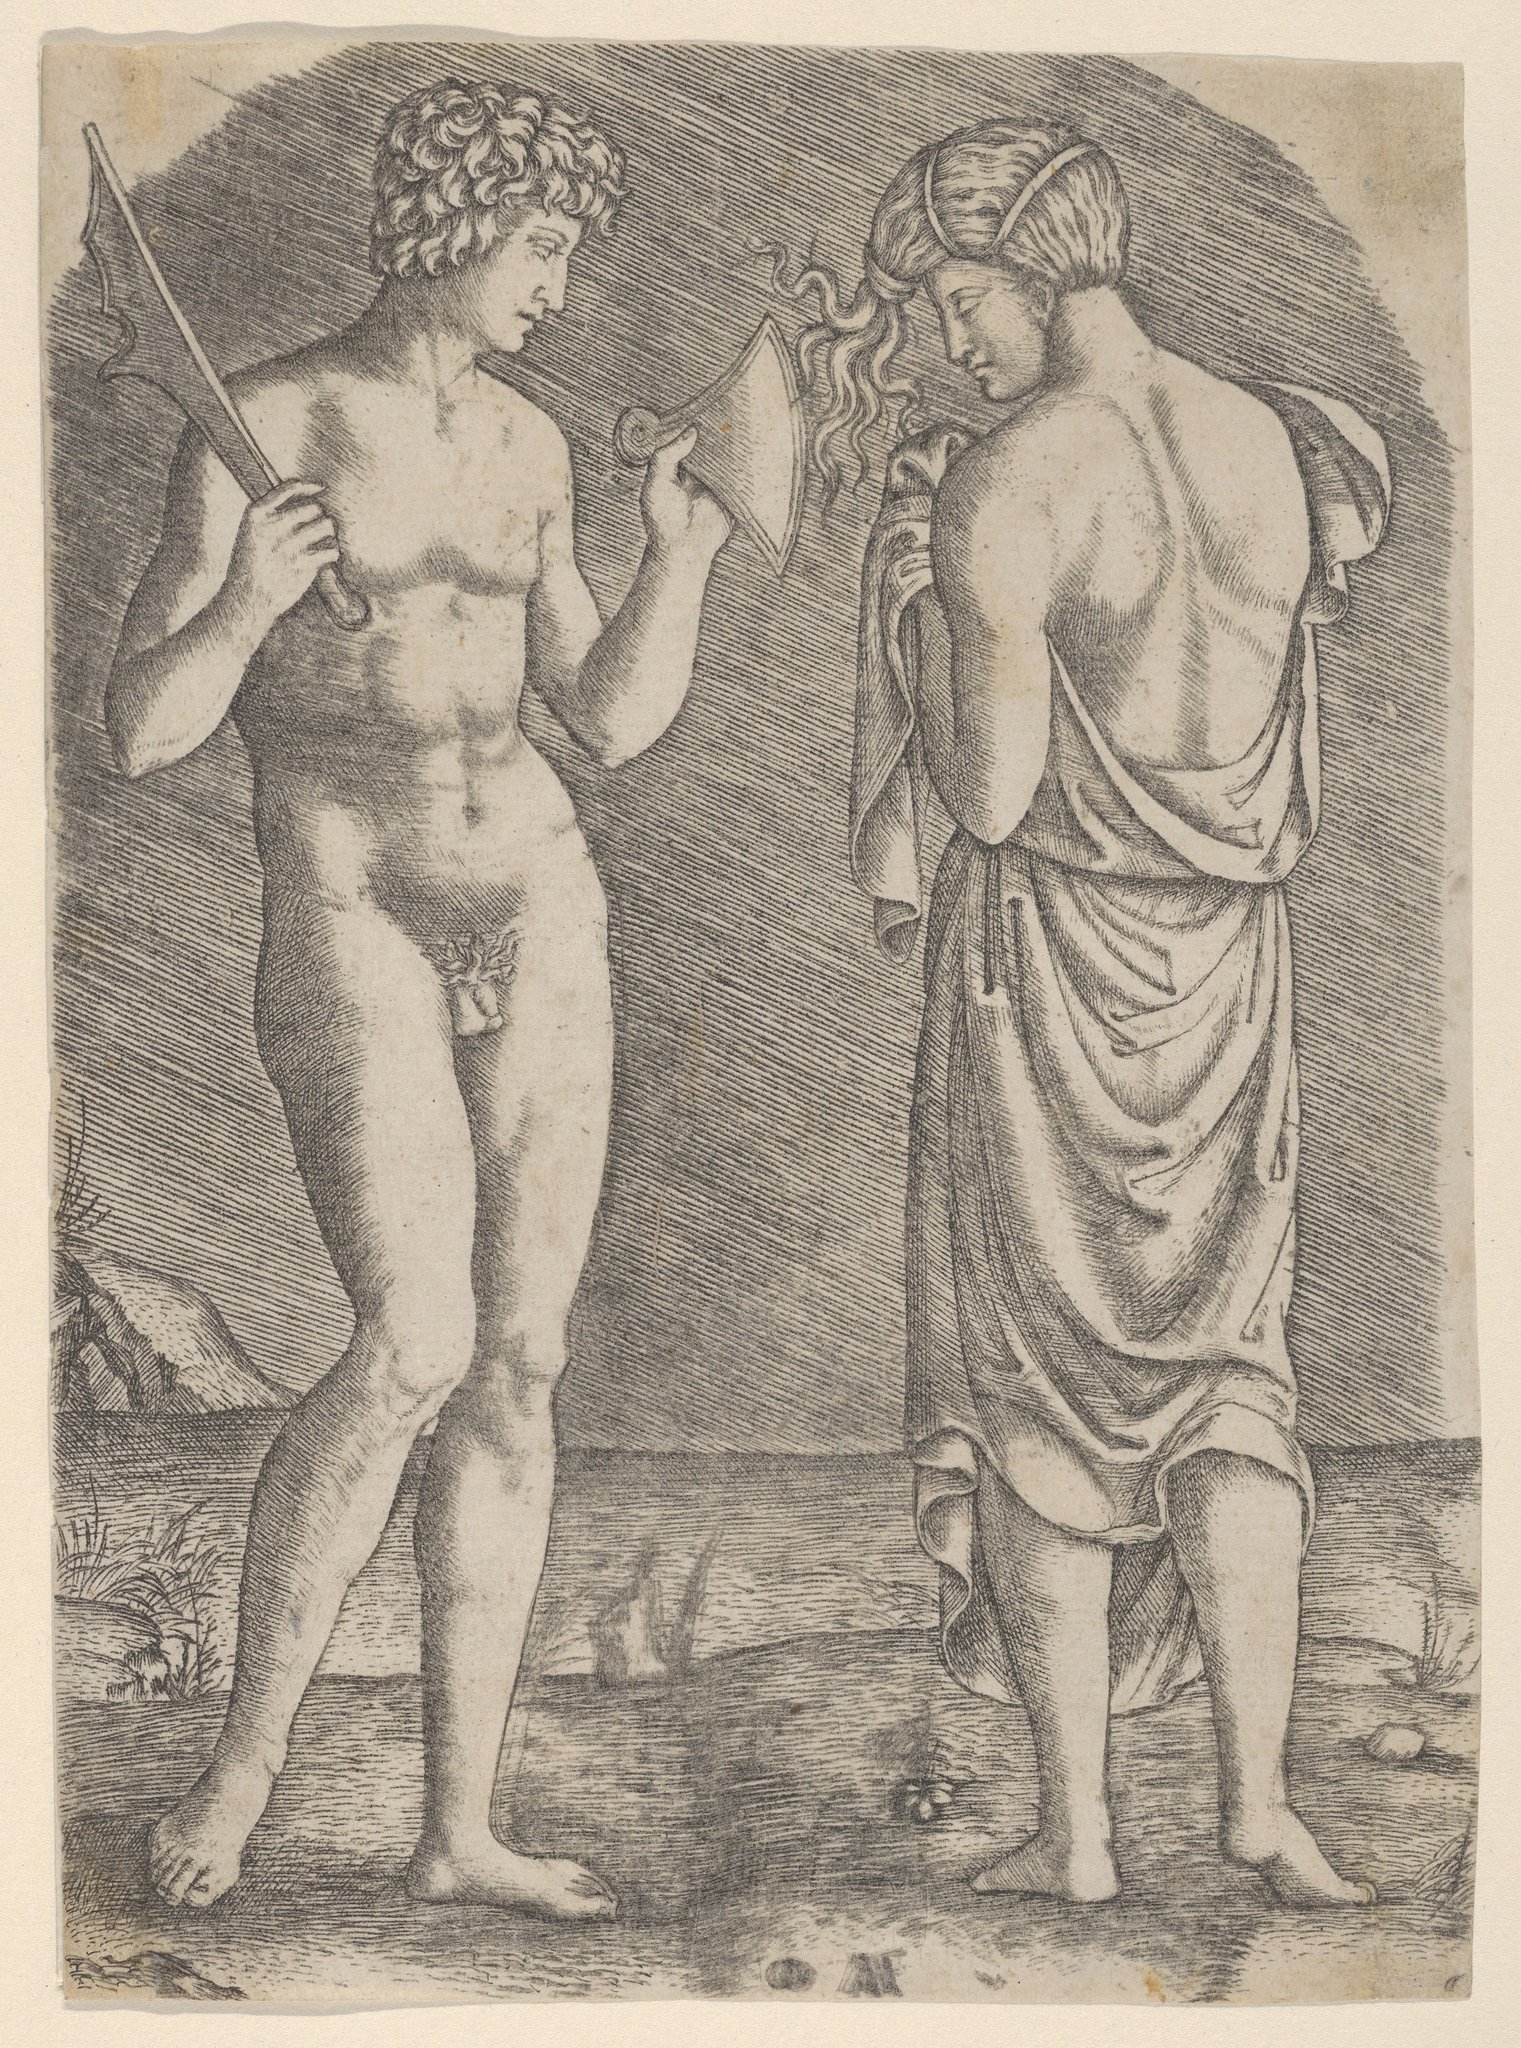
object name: print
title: A naked man at left showing an axe to a woman at right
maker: marcantonio raimondi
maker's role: artist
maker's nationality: italian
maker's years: 1475-1534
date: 1510-1527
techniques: engraving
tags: weapons,male nudes,women,axes